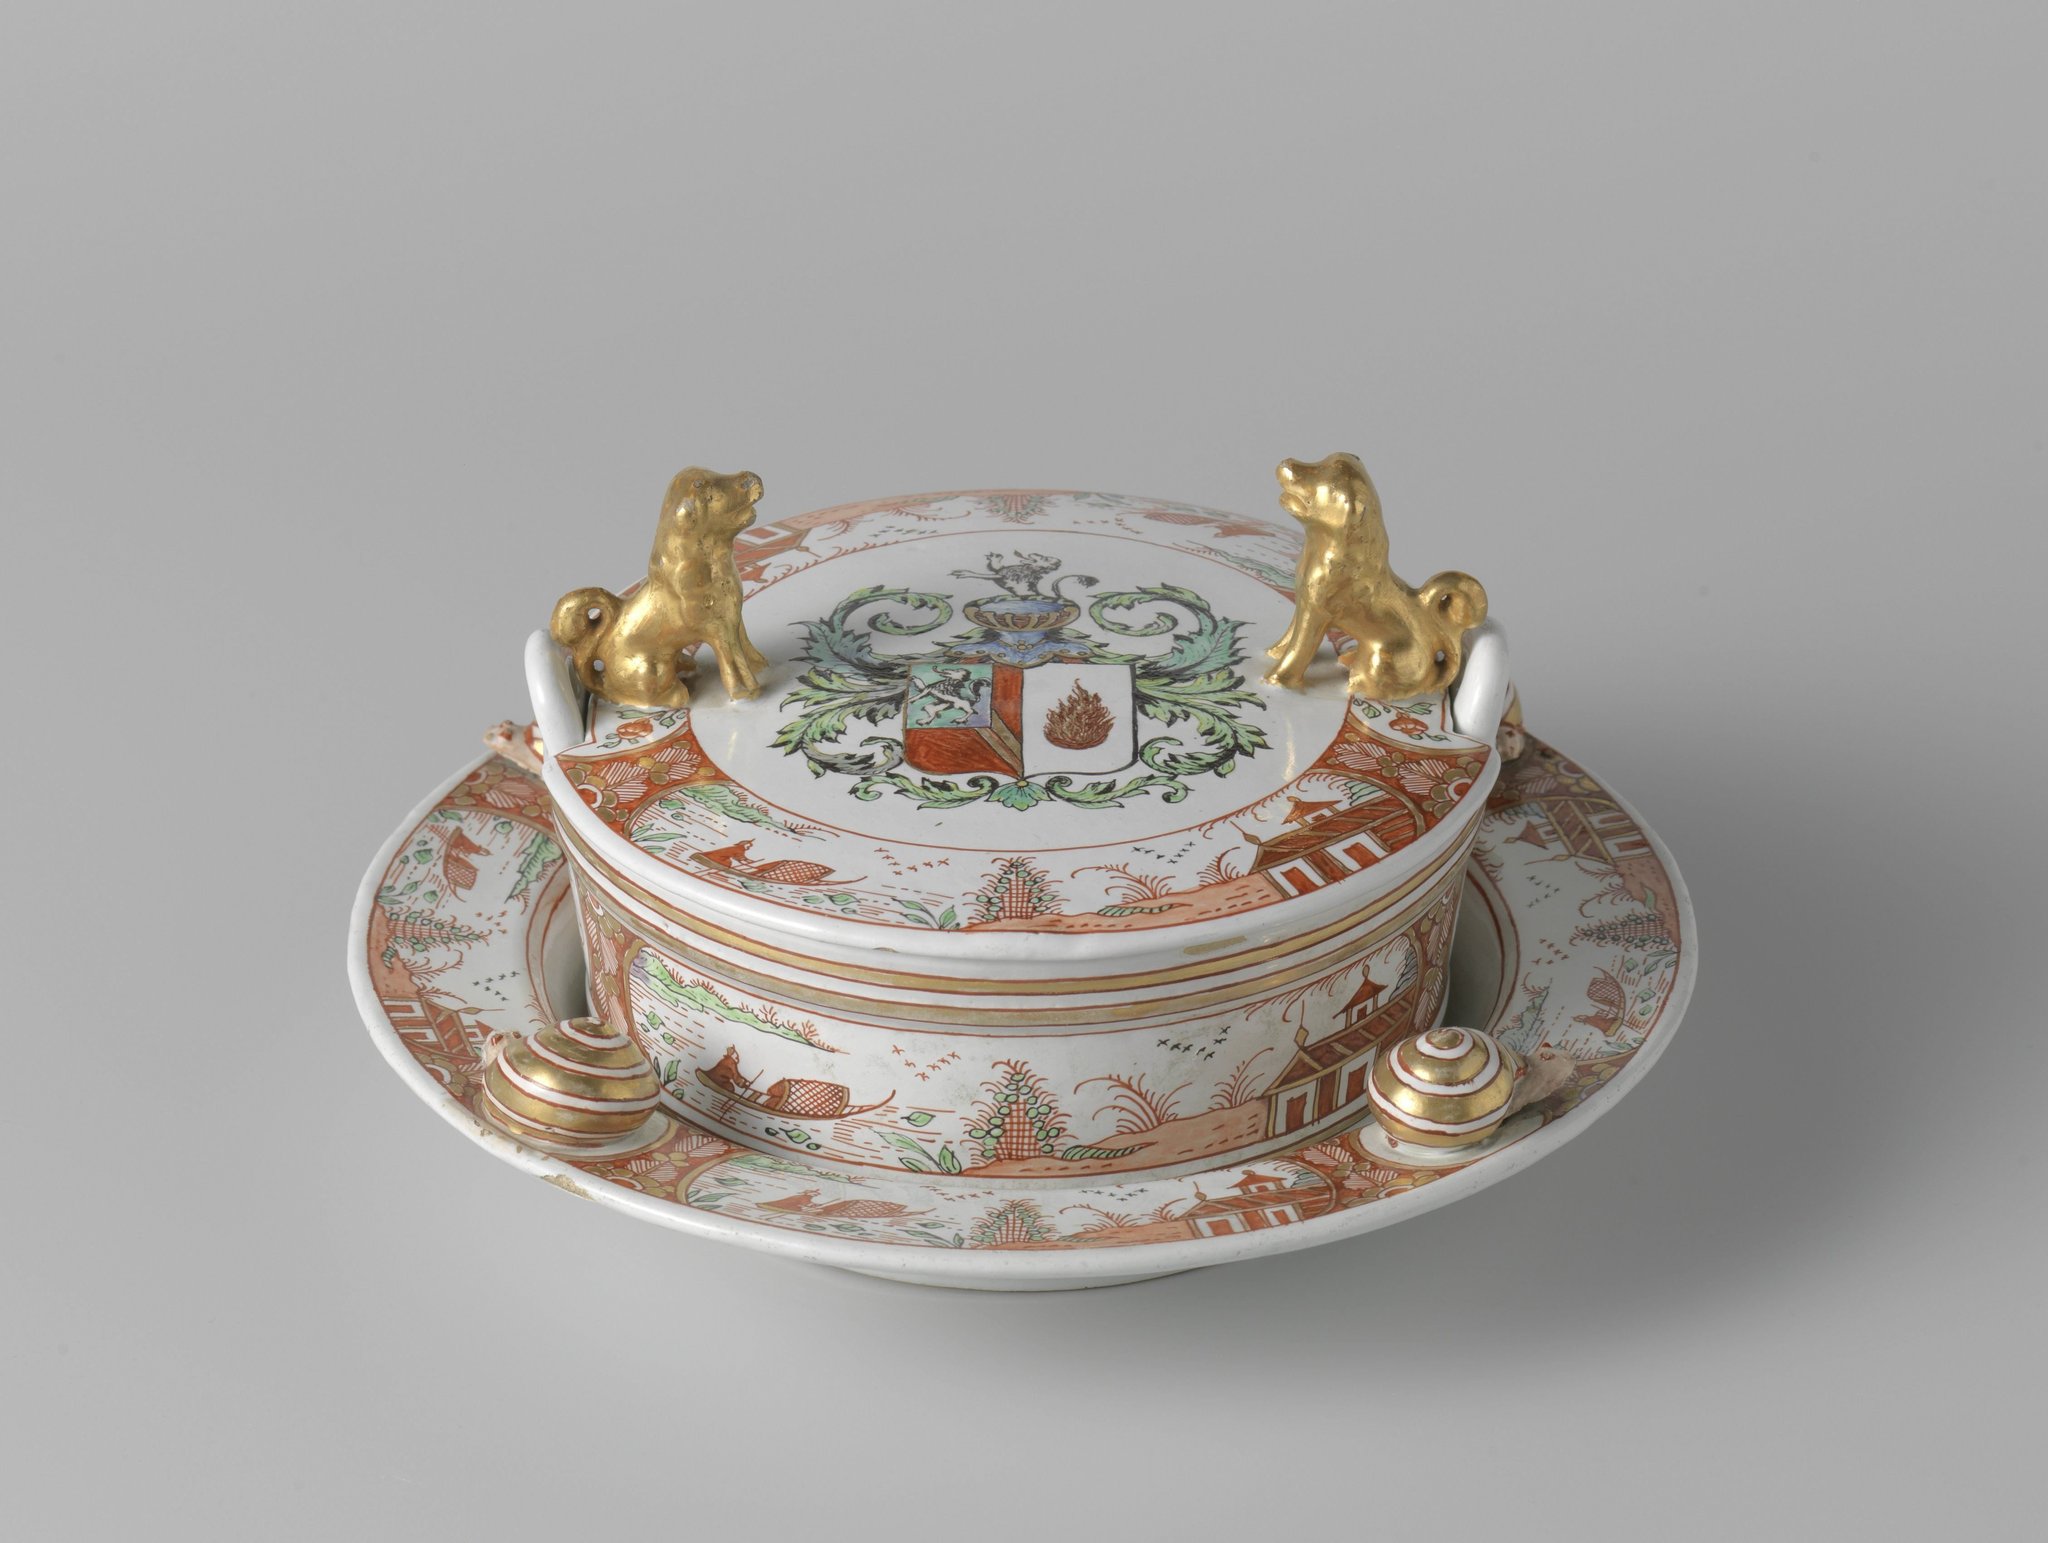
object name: platter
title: Onderschotel van botervloot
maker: Anonymous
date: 1740-1765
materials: faience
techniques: kiln, painted, polychromy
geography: delft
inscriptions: mark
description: Onderschotel van botervloot, veelkleurig beschilderd met het wapen van de familie Josselet. Op de rand van de schotel vier slakken.